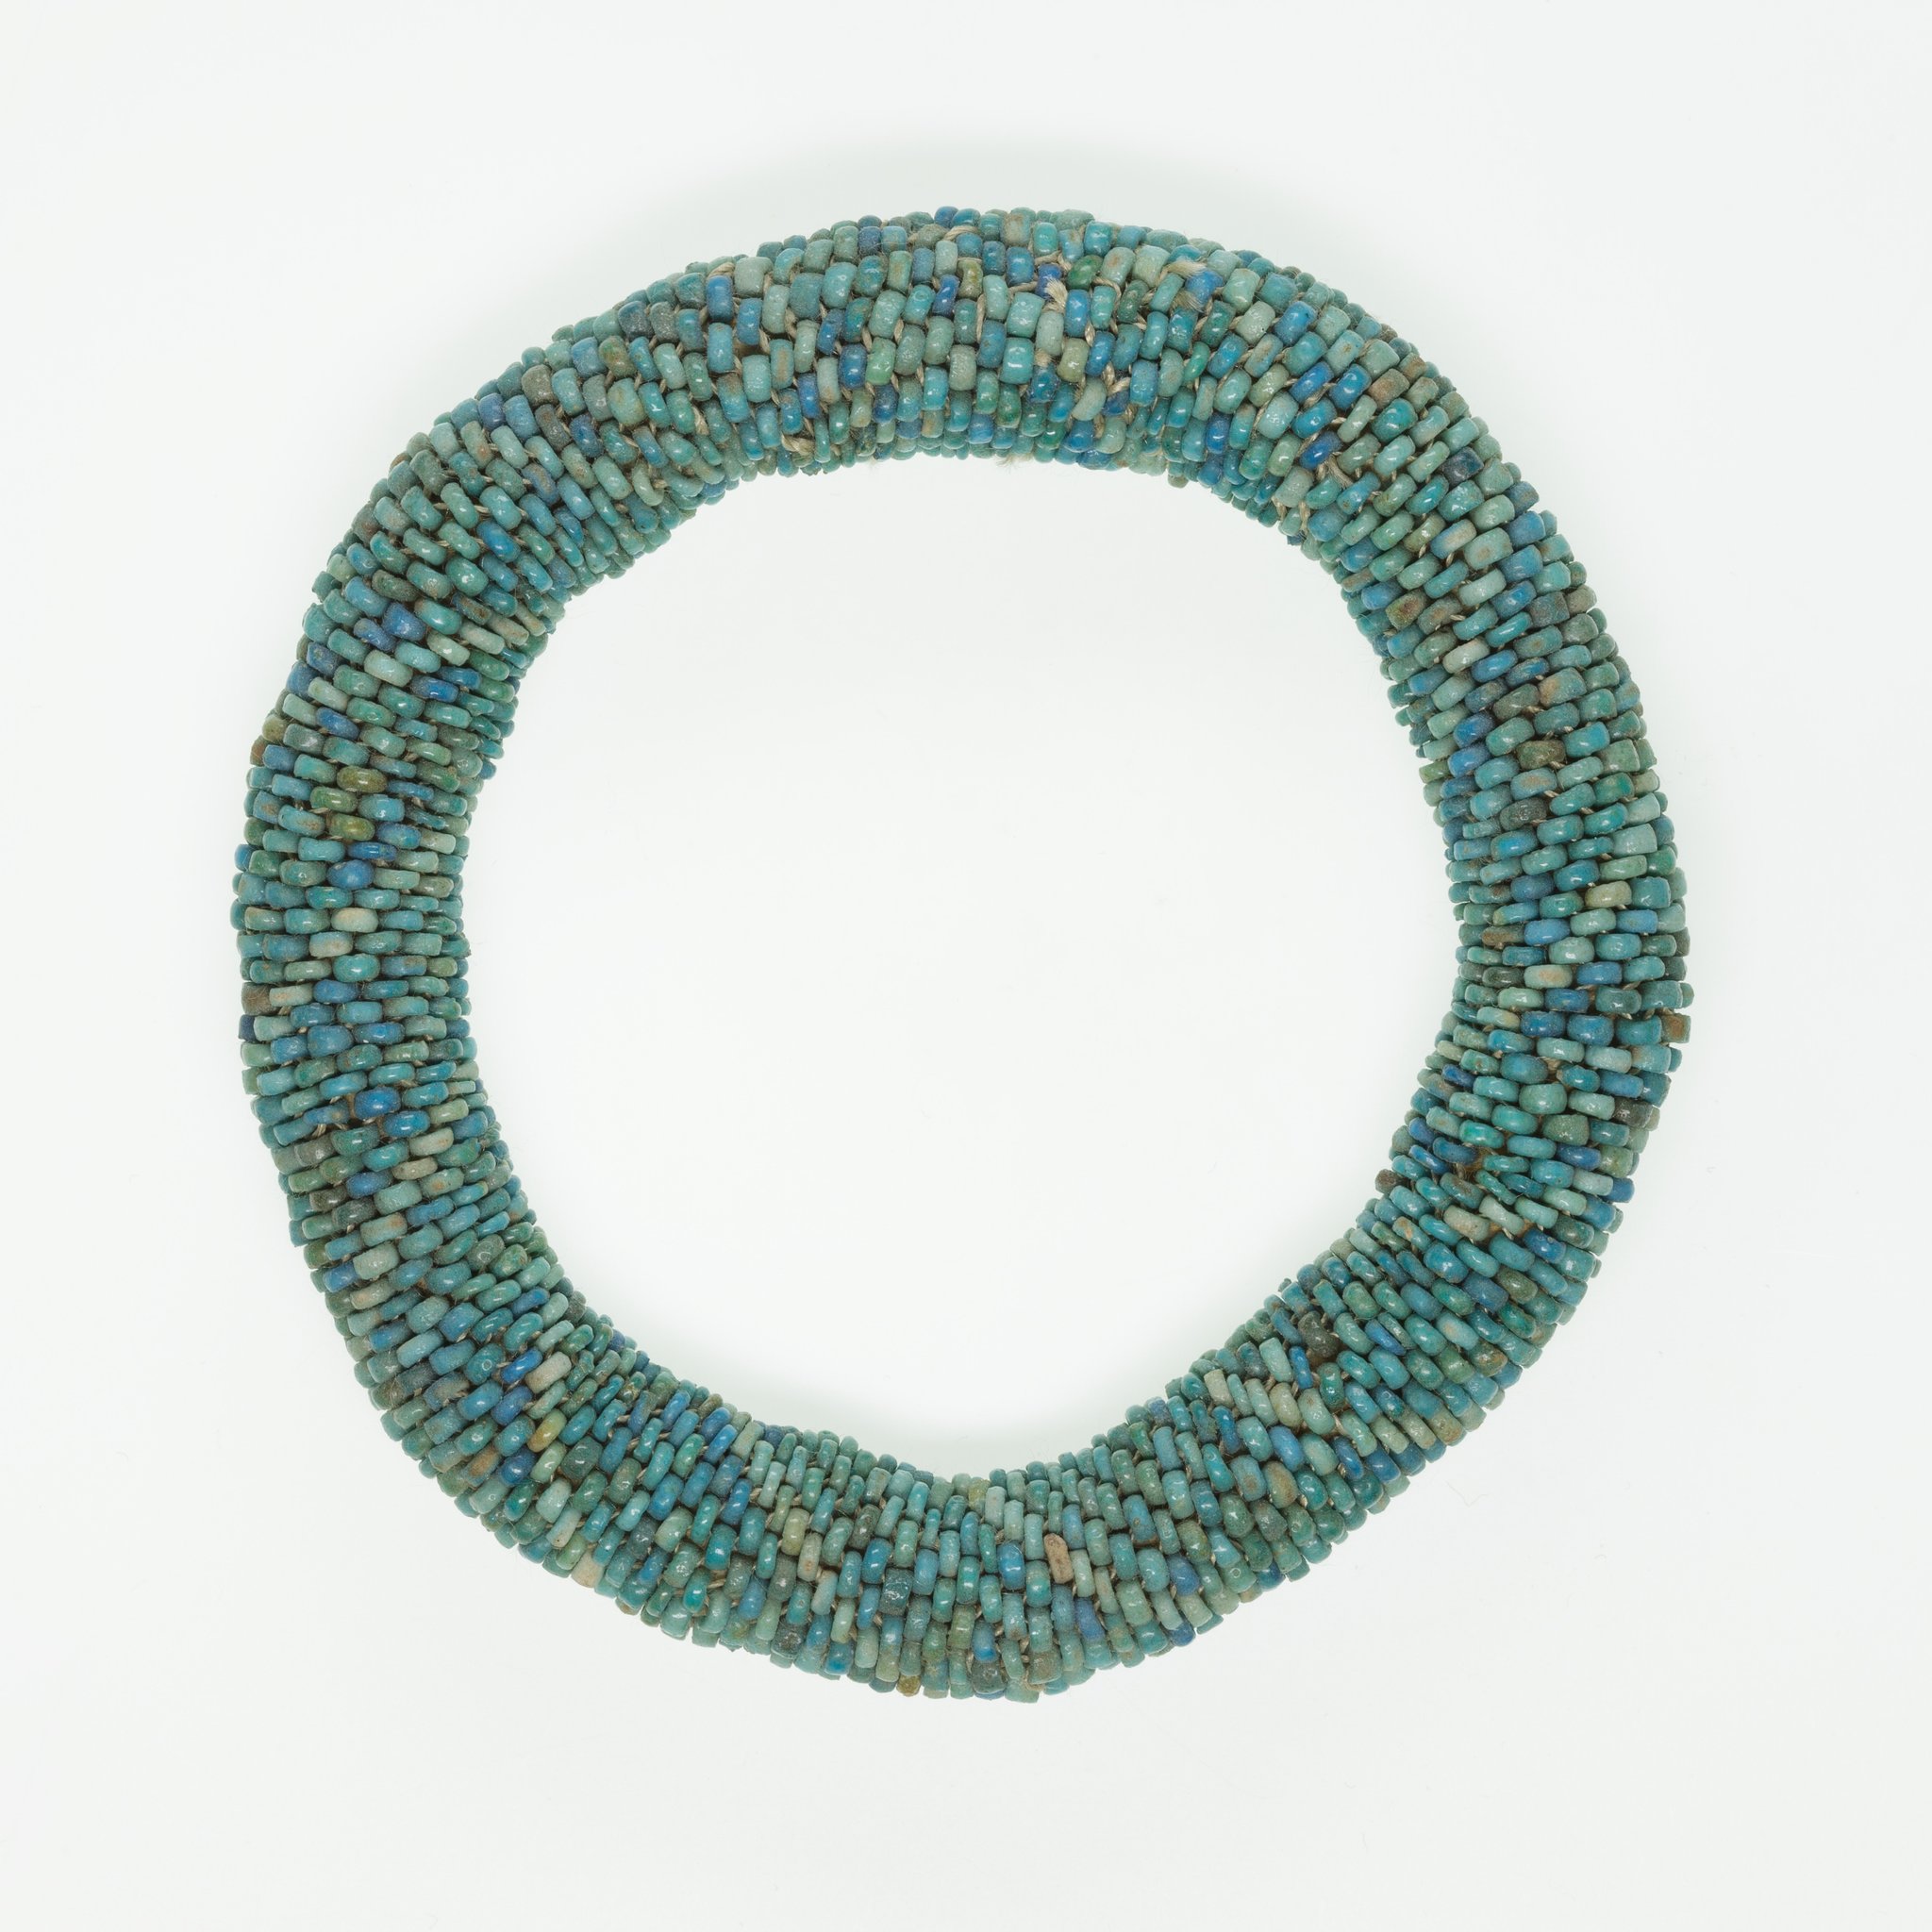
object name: bracelet or armlet, baki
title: Beaded Bracelet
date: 1504-1447 BCE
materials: faience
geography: egypt